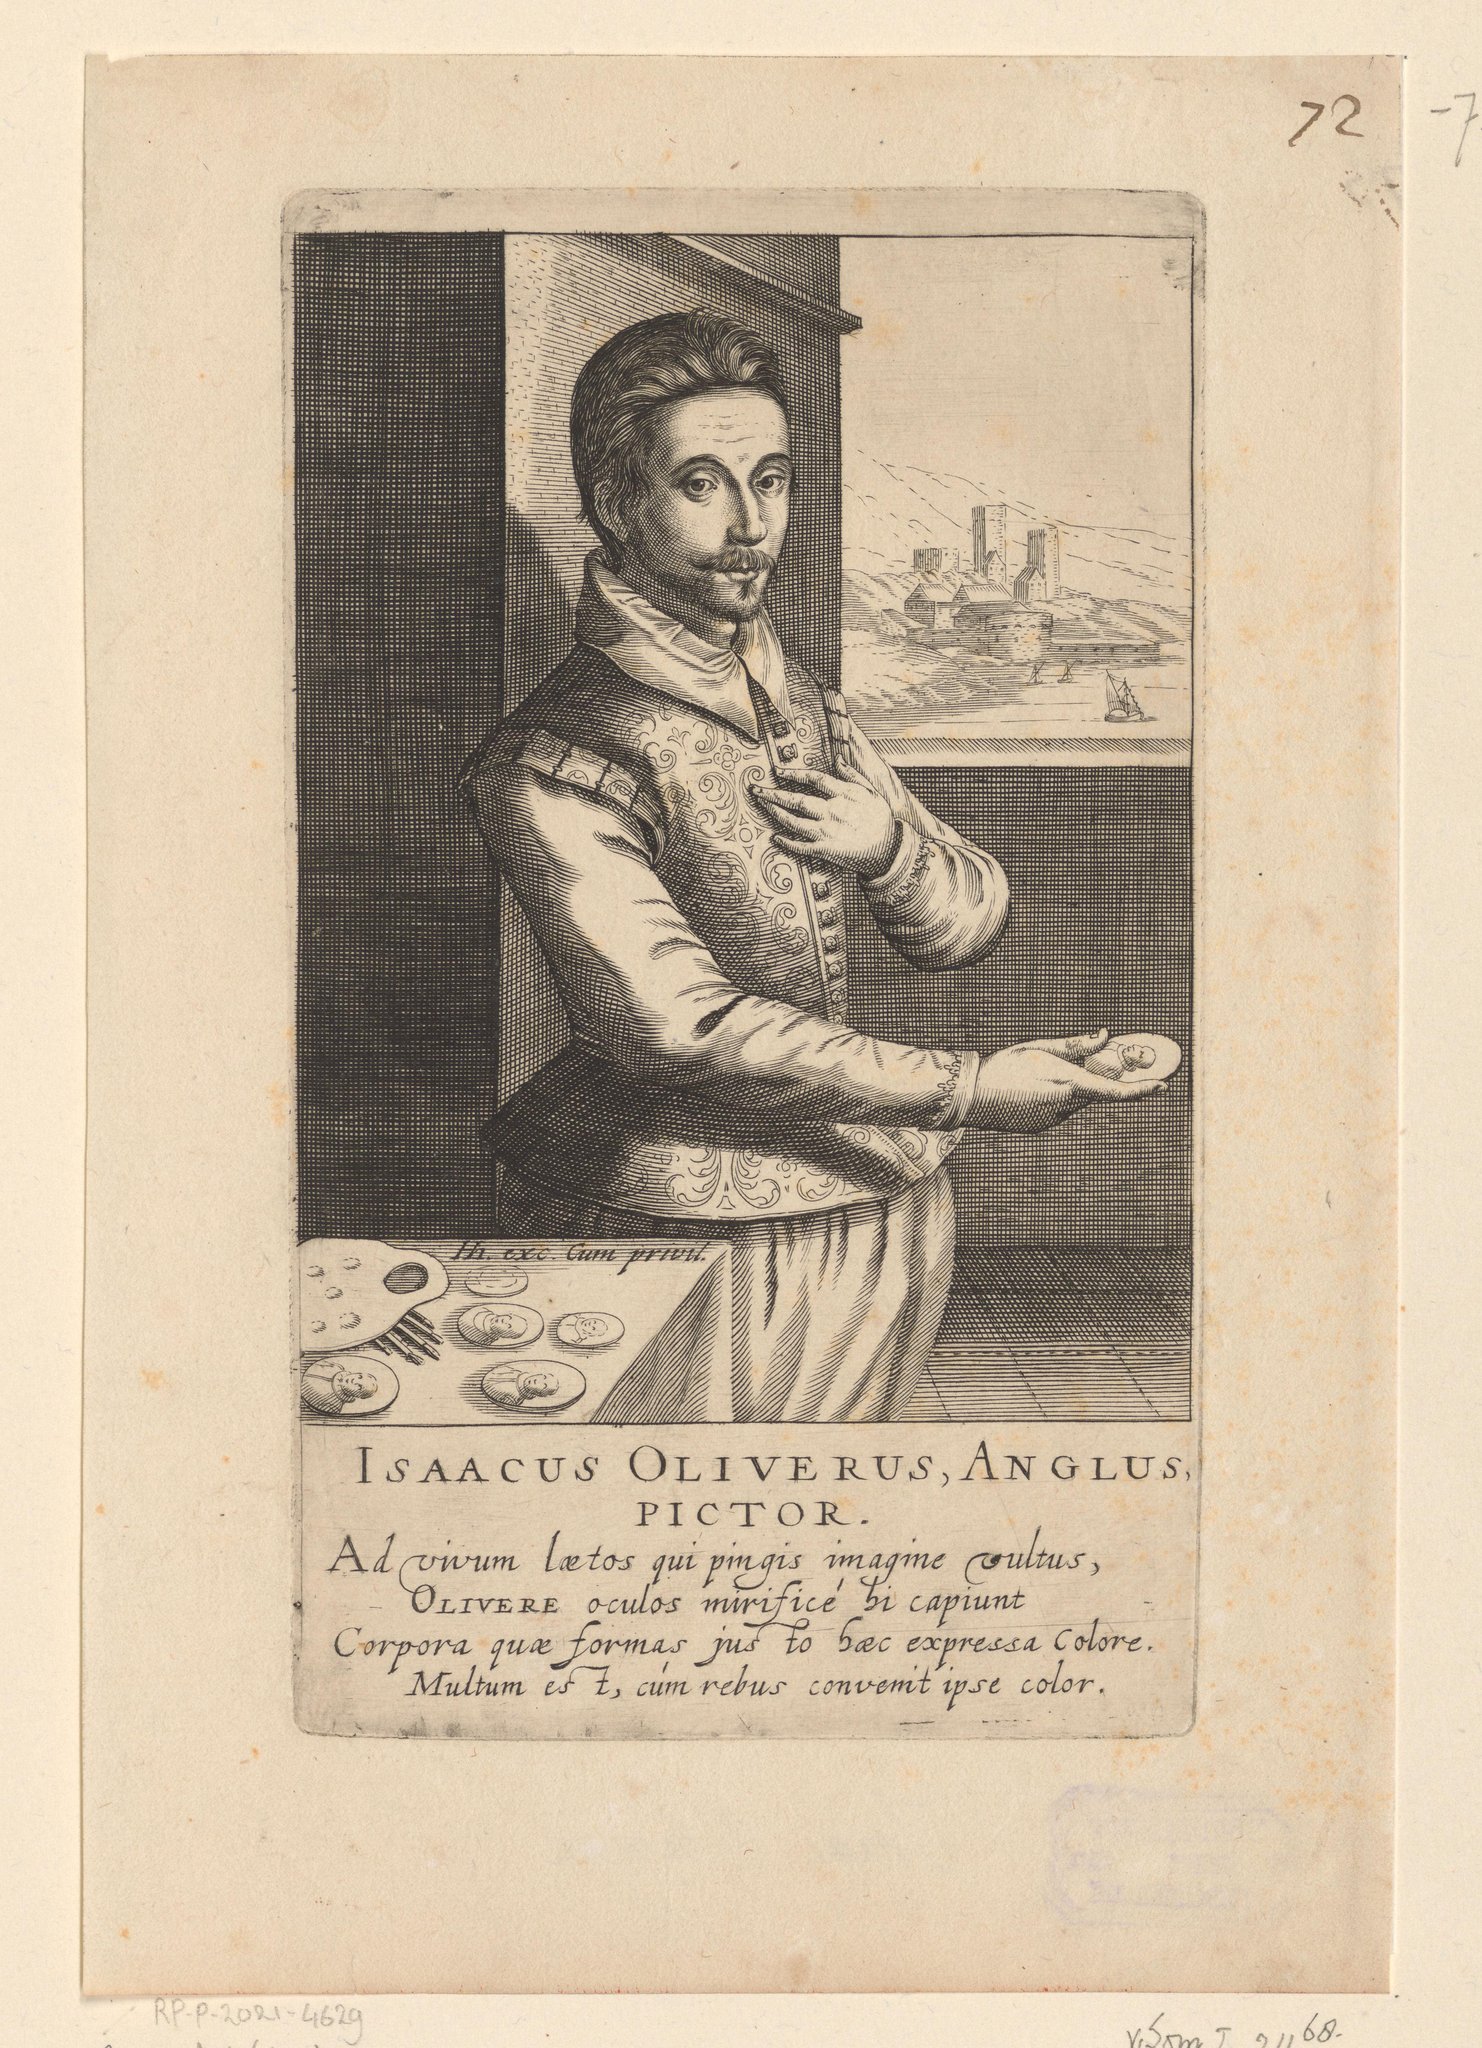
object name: print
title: Pictorum aliquot celebrium praecipuae Germaniae Inferioris effigies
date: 1610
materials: paper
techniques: engraving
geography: the hague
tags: draughtsman, isaac oliver, historical persons, portrait, self-portrait of painter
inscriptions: watermark:, collector's mark: Lugt 11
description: Prent uit deel 3 van de serie Pictorum Aliquot Celebrium Praecipuae Germaniae Inferioris Effigies. Serie van 72 kunstenaarsportretten vervaardigd door Hendrick Hondius I, Simon Frisius, Andries Jacobsz. Stock en Robert de Baudous.